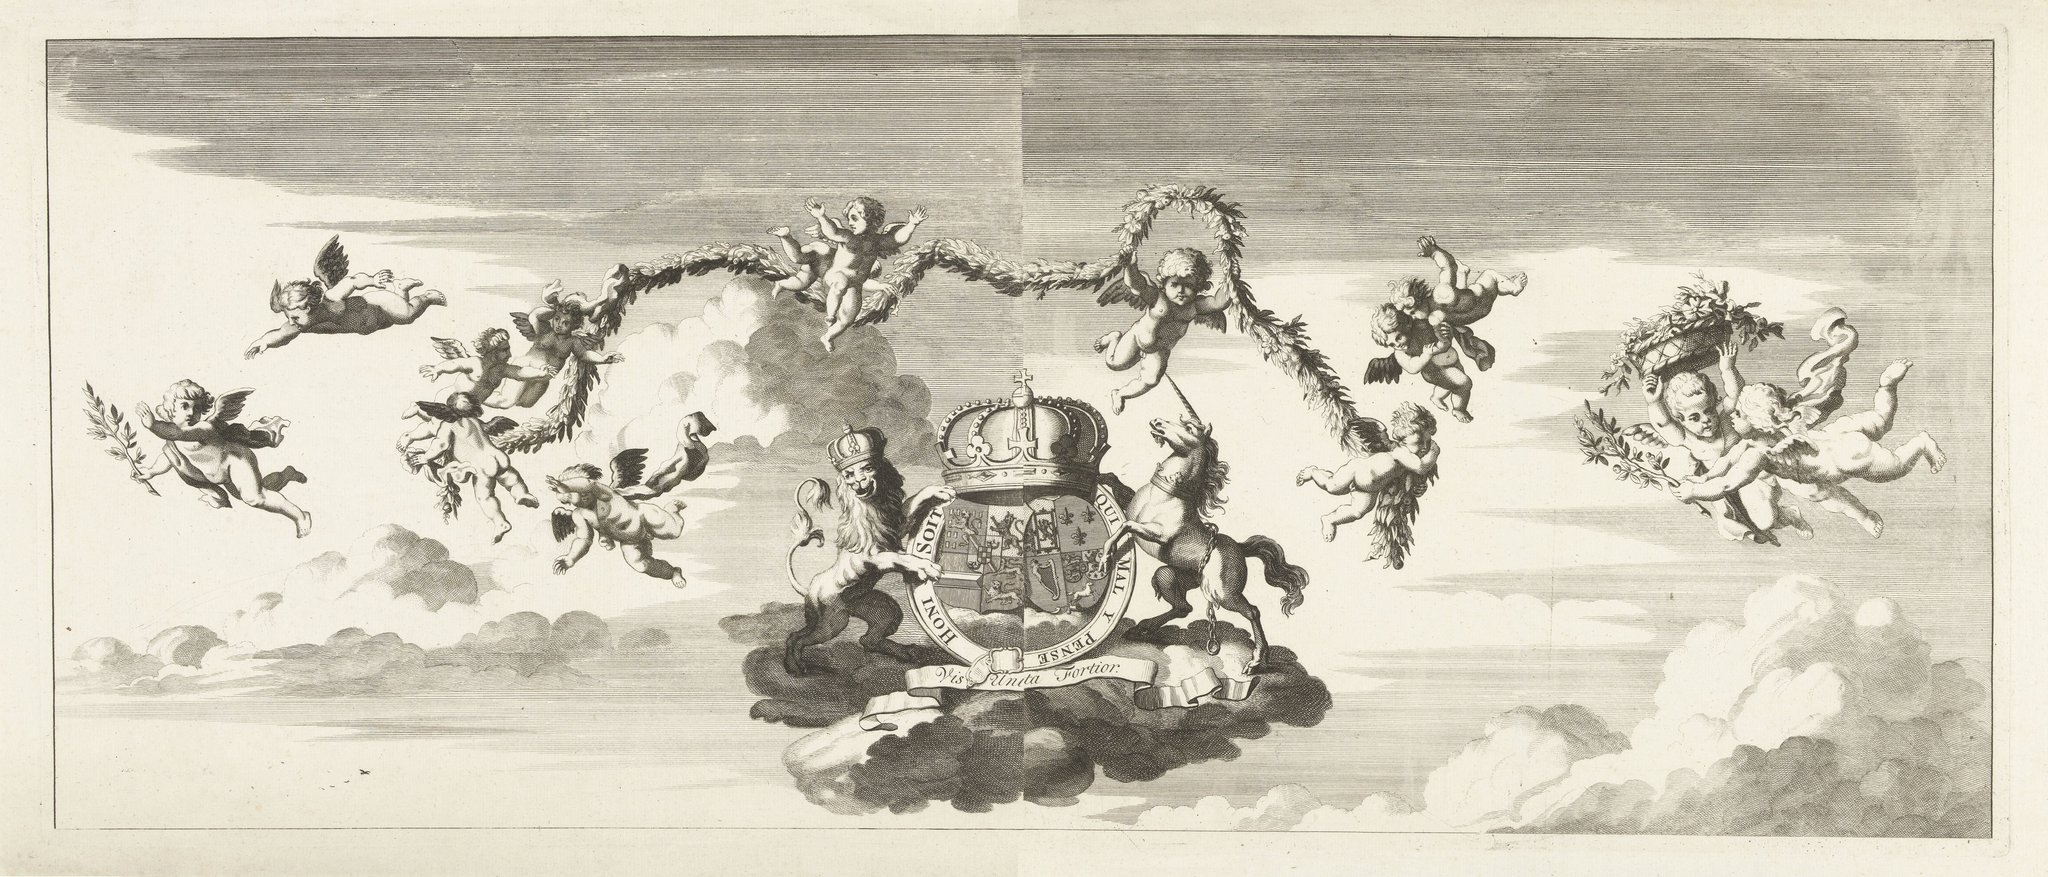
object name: print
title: Wapens van prins Willem IV en Anna van Engeland, 1734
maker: Anonymous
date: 1734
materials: paper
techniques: engraving, etching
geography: northern netherlands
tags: willem iv (prins van oranje-nassau), the hague, anna van hannover, armorial bearing, heraldry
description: De wapens van prins Willem IV en prinses Anna van Engeland, gehuwd op 25 maart 1734, in de wolken met engeltjes met een festoen, aan de linkerzijde van het wapen de Nederlandse Leeuw en aan de rechterzijde de Britse eenhoorn als wapendrager. Ongemonteerd geheel bestaande uit twee delen.